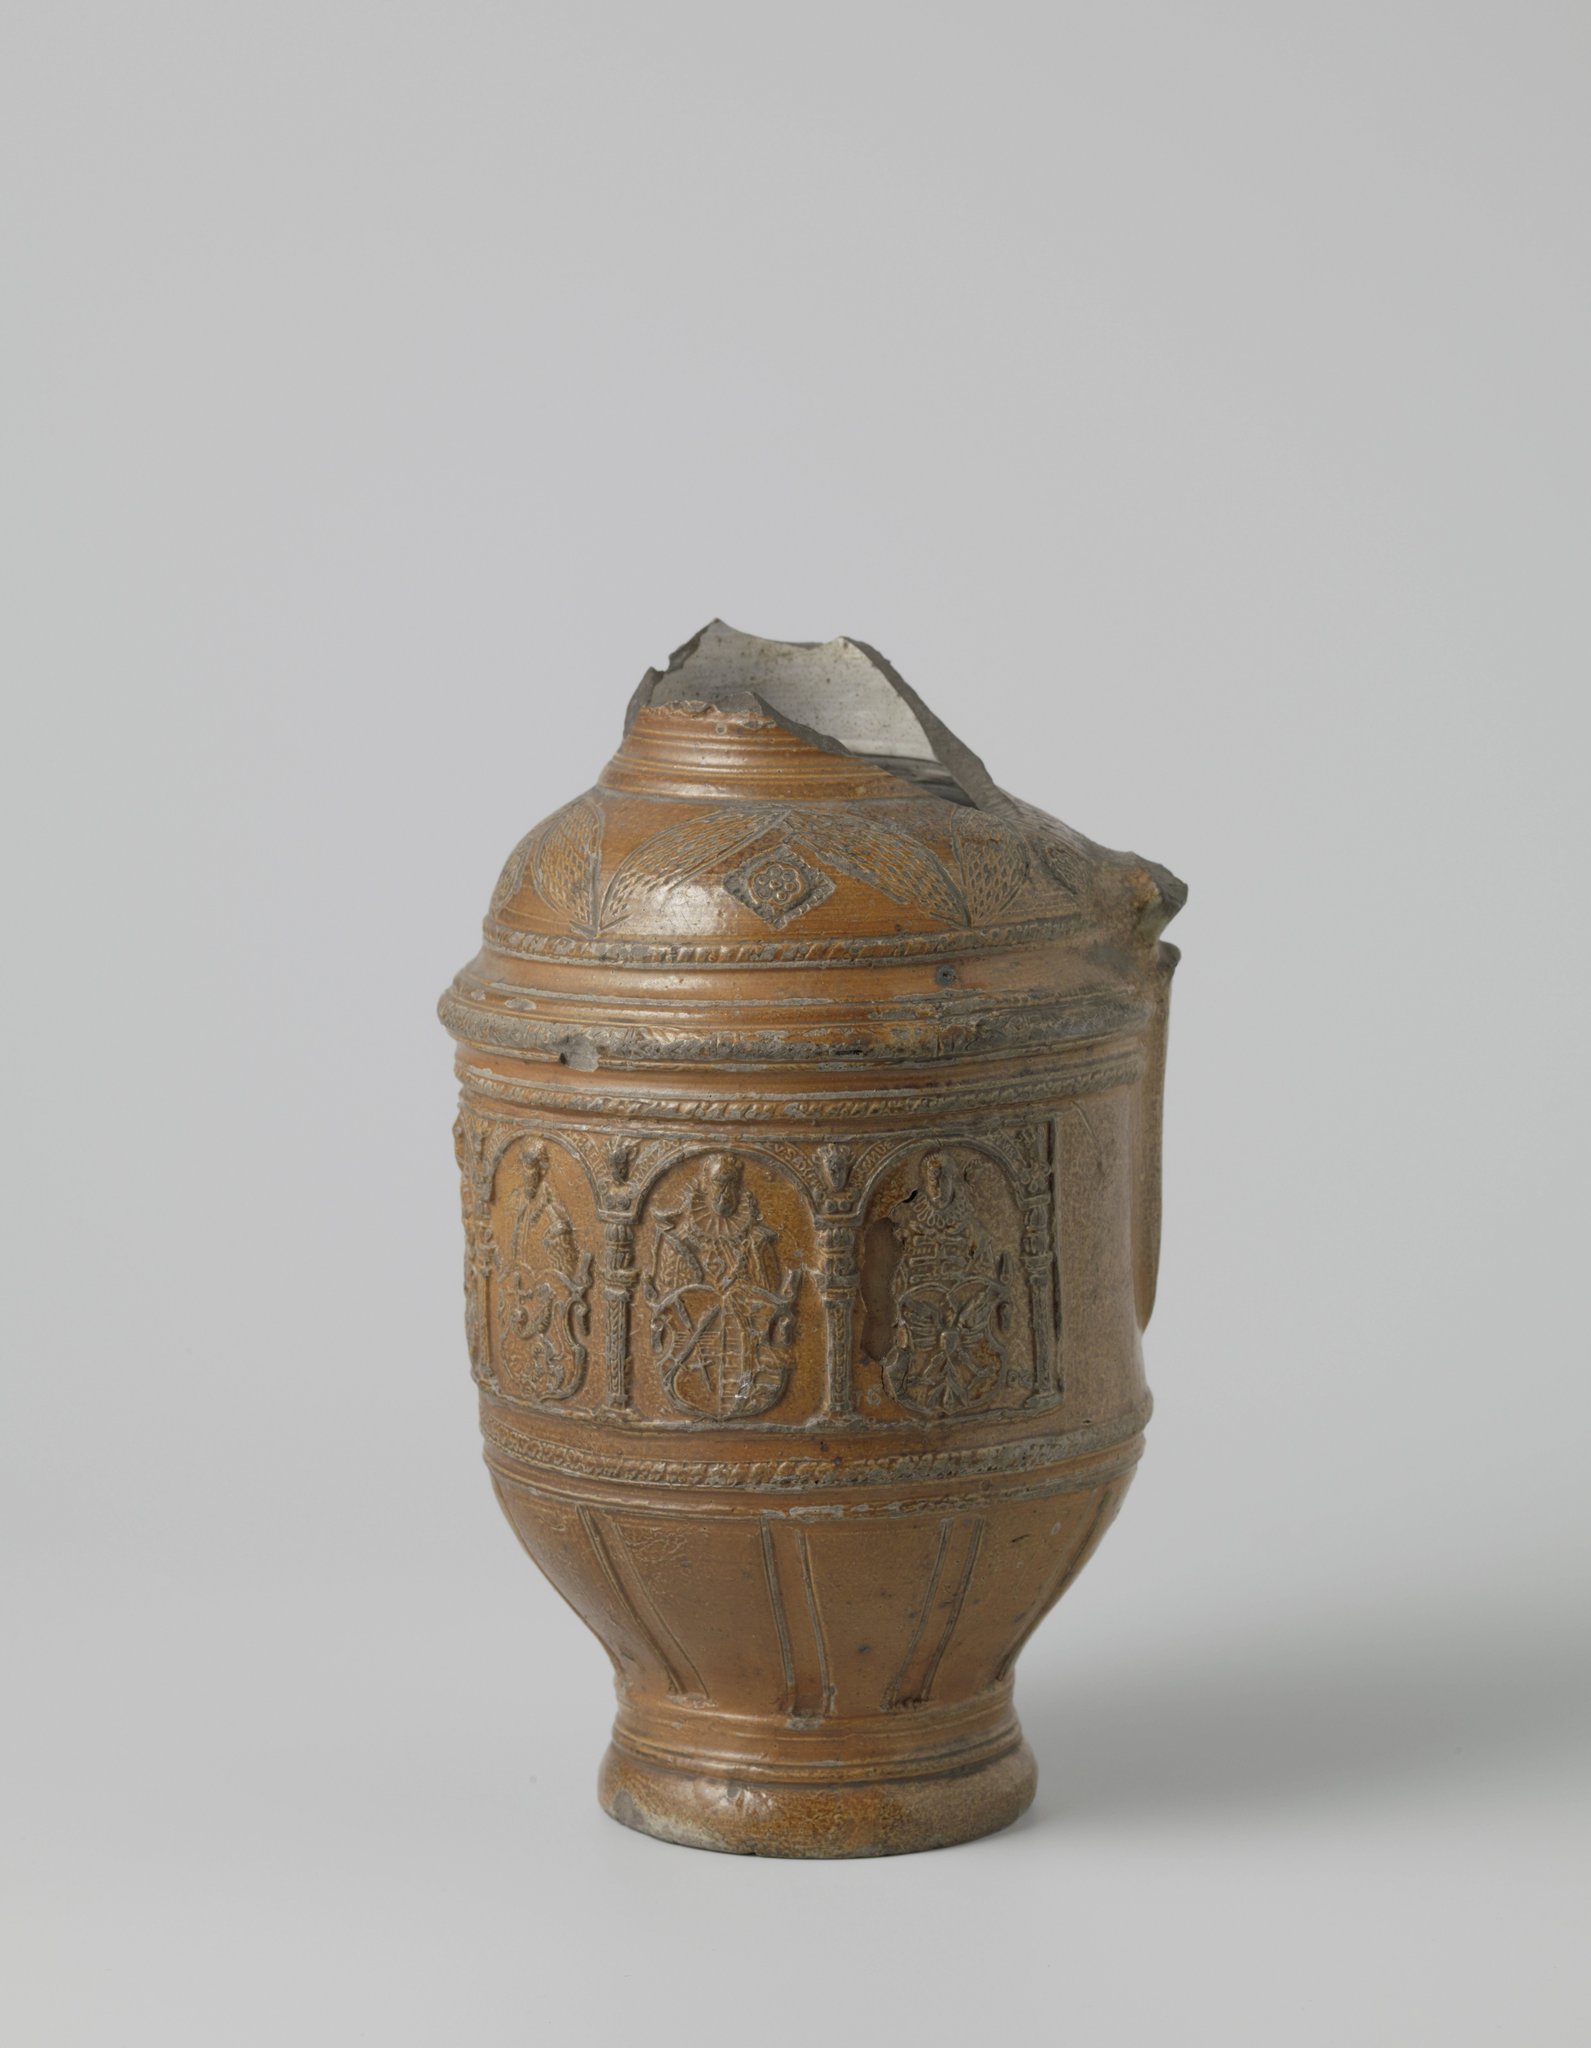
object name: jug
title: Fragment of a jug with a representation of the electors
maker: Anonymous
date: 1602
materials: engobe, glaze, stoneware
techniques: printing, firing, forming, relief, turning, vitrification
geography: raeren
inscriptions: date: ‘1602’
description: Fragment van een kruik van steengoed op hoge voet met een cilindrisch lichaam en ronde schouder. Nek en oor ontbreken. Profielen op het lichaam en de voet. Bedekt met een bruine engobe. Op de buik in reliëf een gedrukte en opgelegde band met bogen. Onder elke boog is een keurvorst met zijn respectievelijke wapen afgebeeld, met in de boog zijn titel. In het meest rechtse vak de datum '1602'. Het onderste deel van de buik loopt schuin af naar de voet en is bedekt met ingegrifte vakken. Op de schouder ovale medaillons met kerfsnede en gedrukte rozetten in een ruit. Raeren.